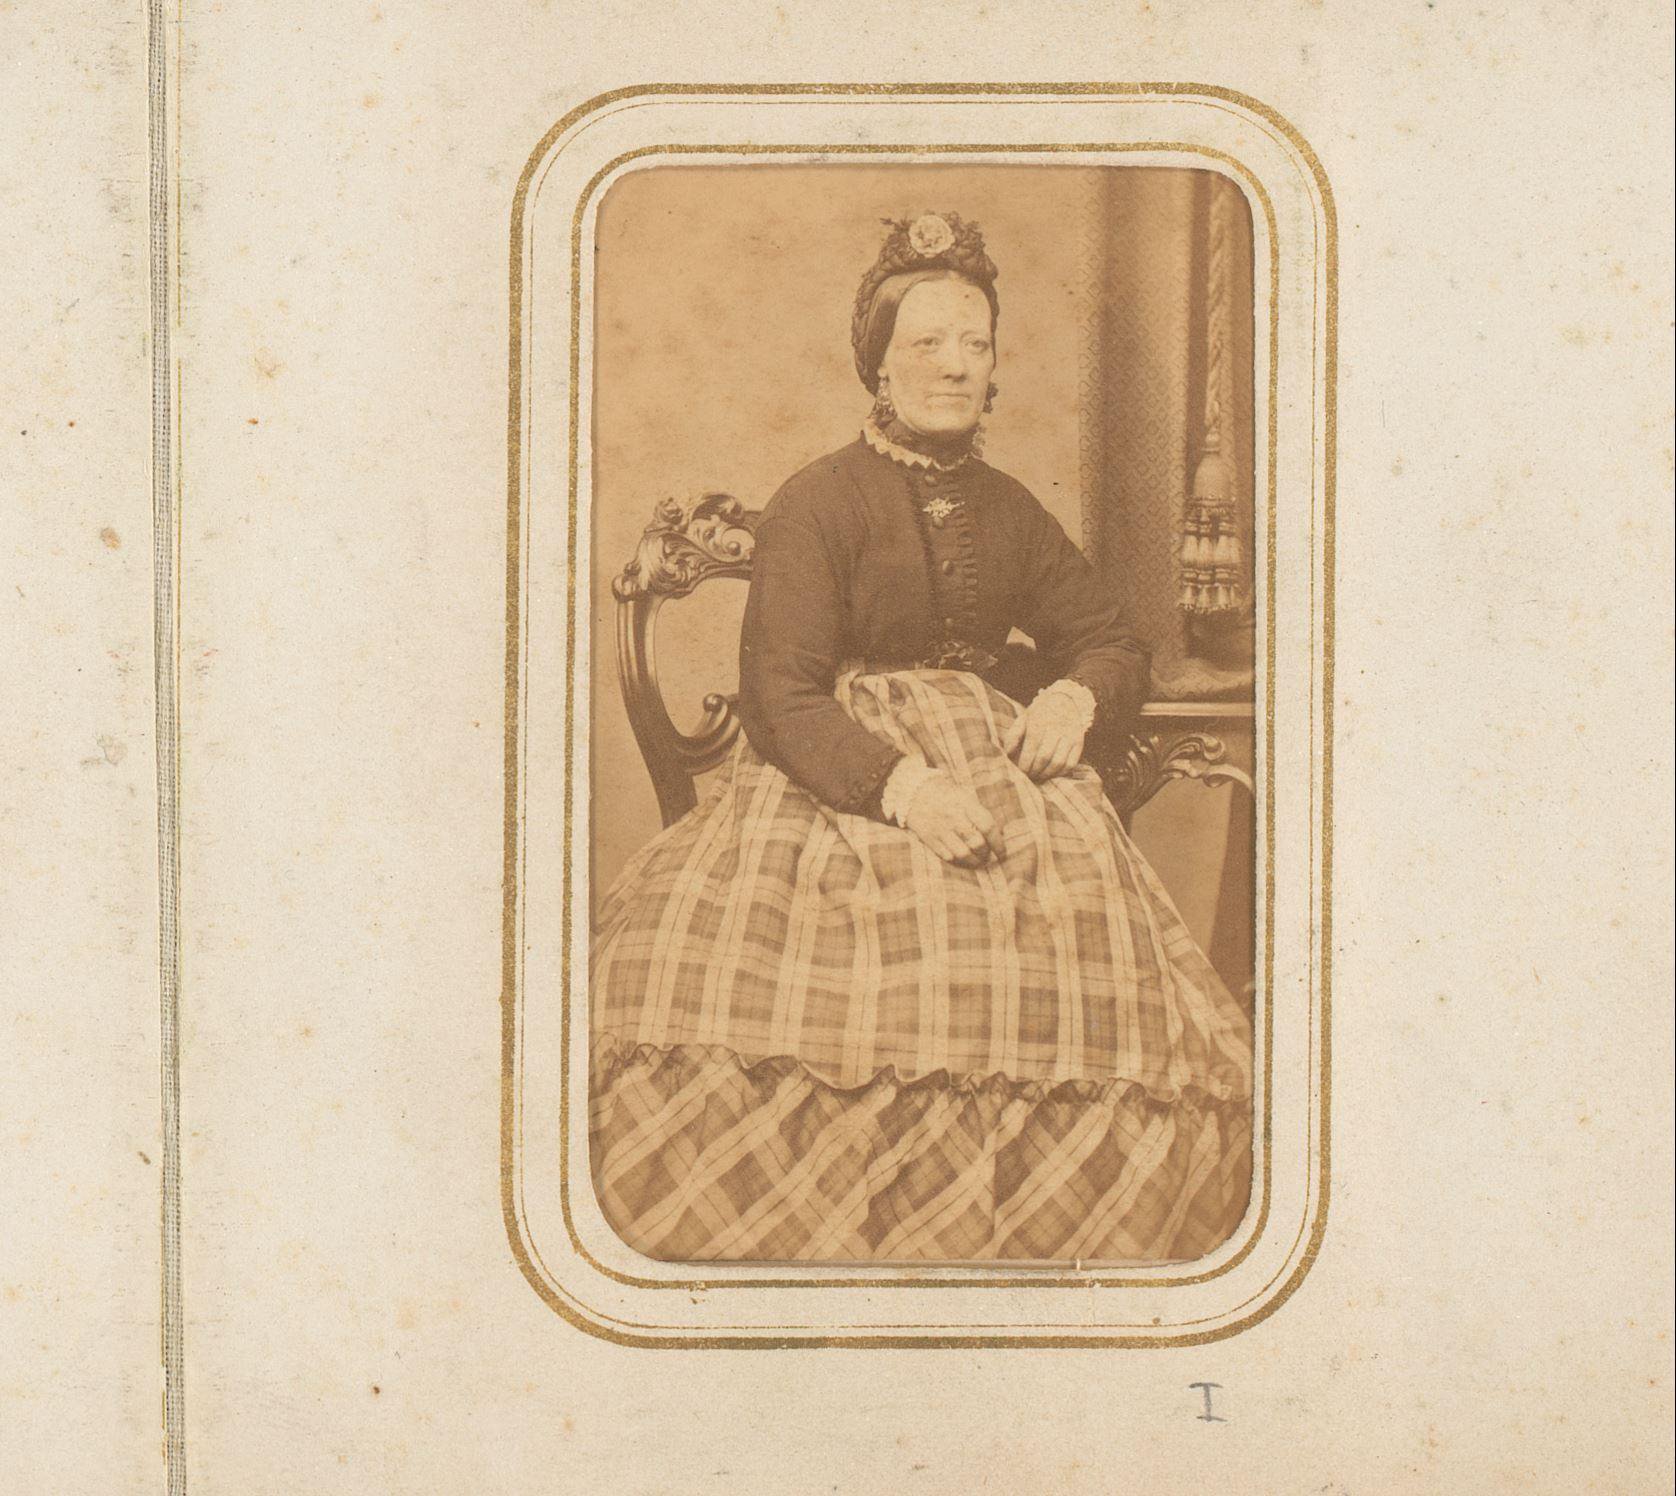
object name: photograph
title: Portret van een zittende oude vrouw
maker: willem gerhardus kuijer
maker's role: fotograaf, hoffotograaf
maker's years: 1834-1899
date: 1862-1899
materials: cardboard, photographic support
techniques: albumen print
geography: amsterdam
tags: historical persons - bb - woman, old woman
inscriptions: inscription: ‘Photographisch Atelier/ van/ W.G. Kuijer/ Rozengracht D.D. 455/ Amsterdam’